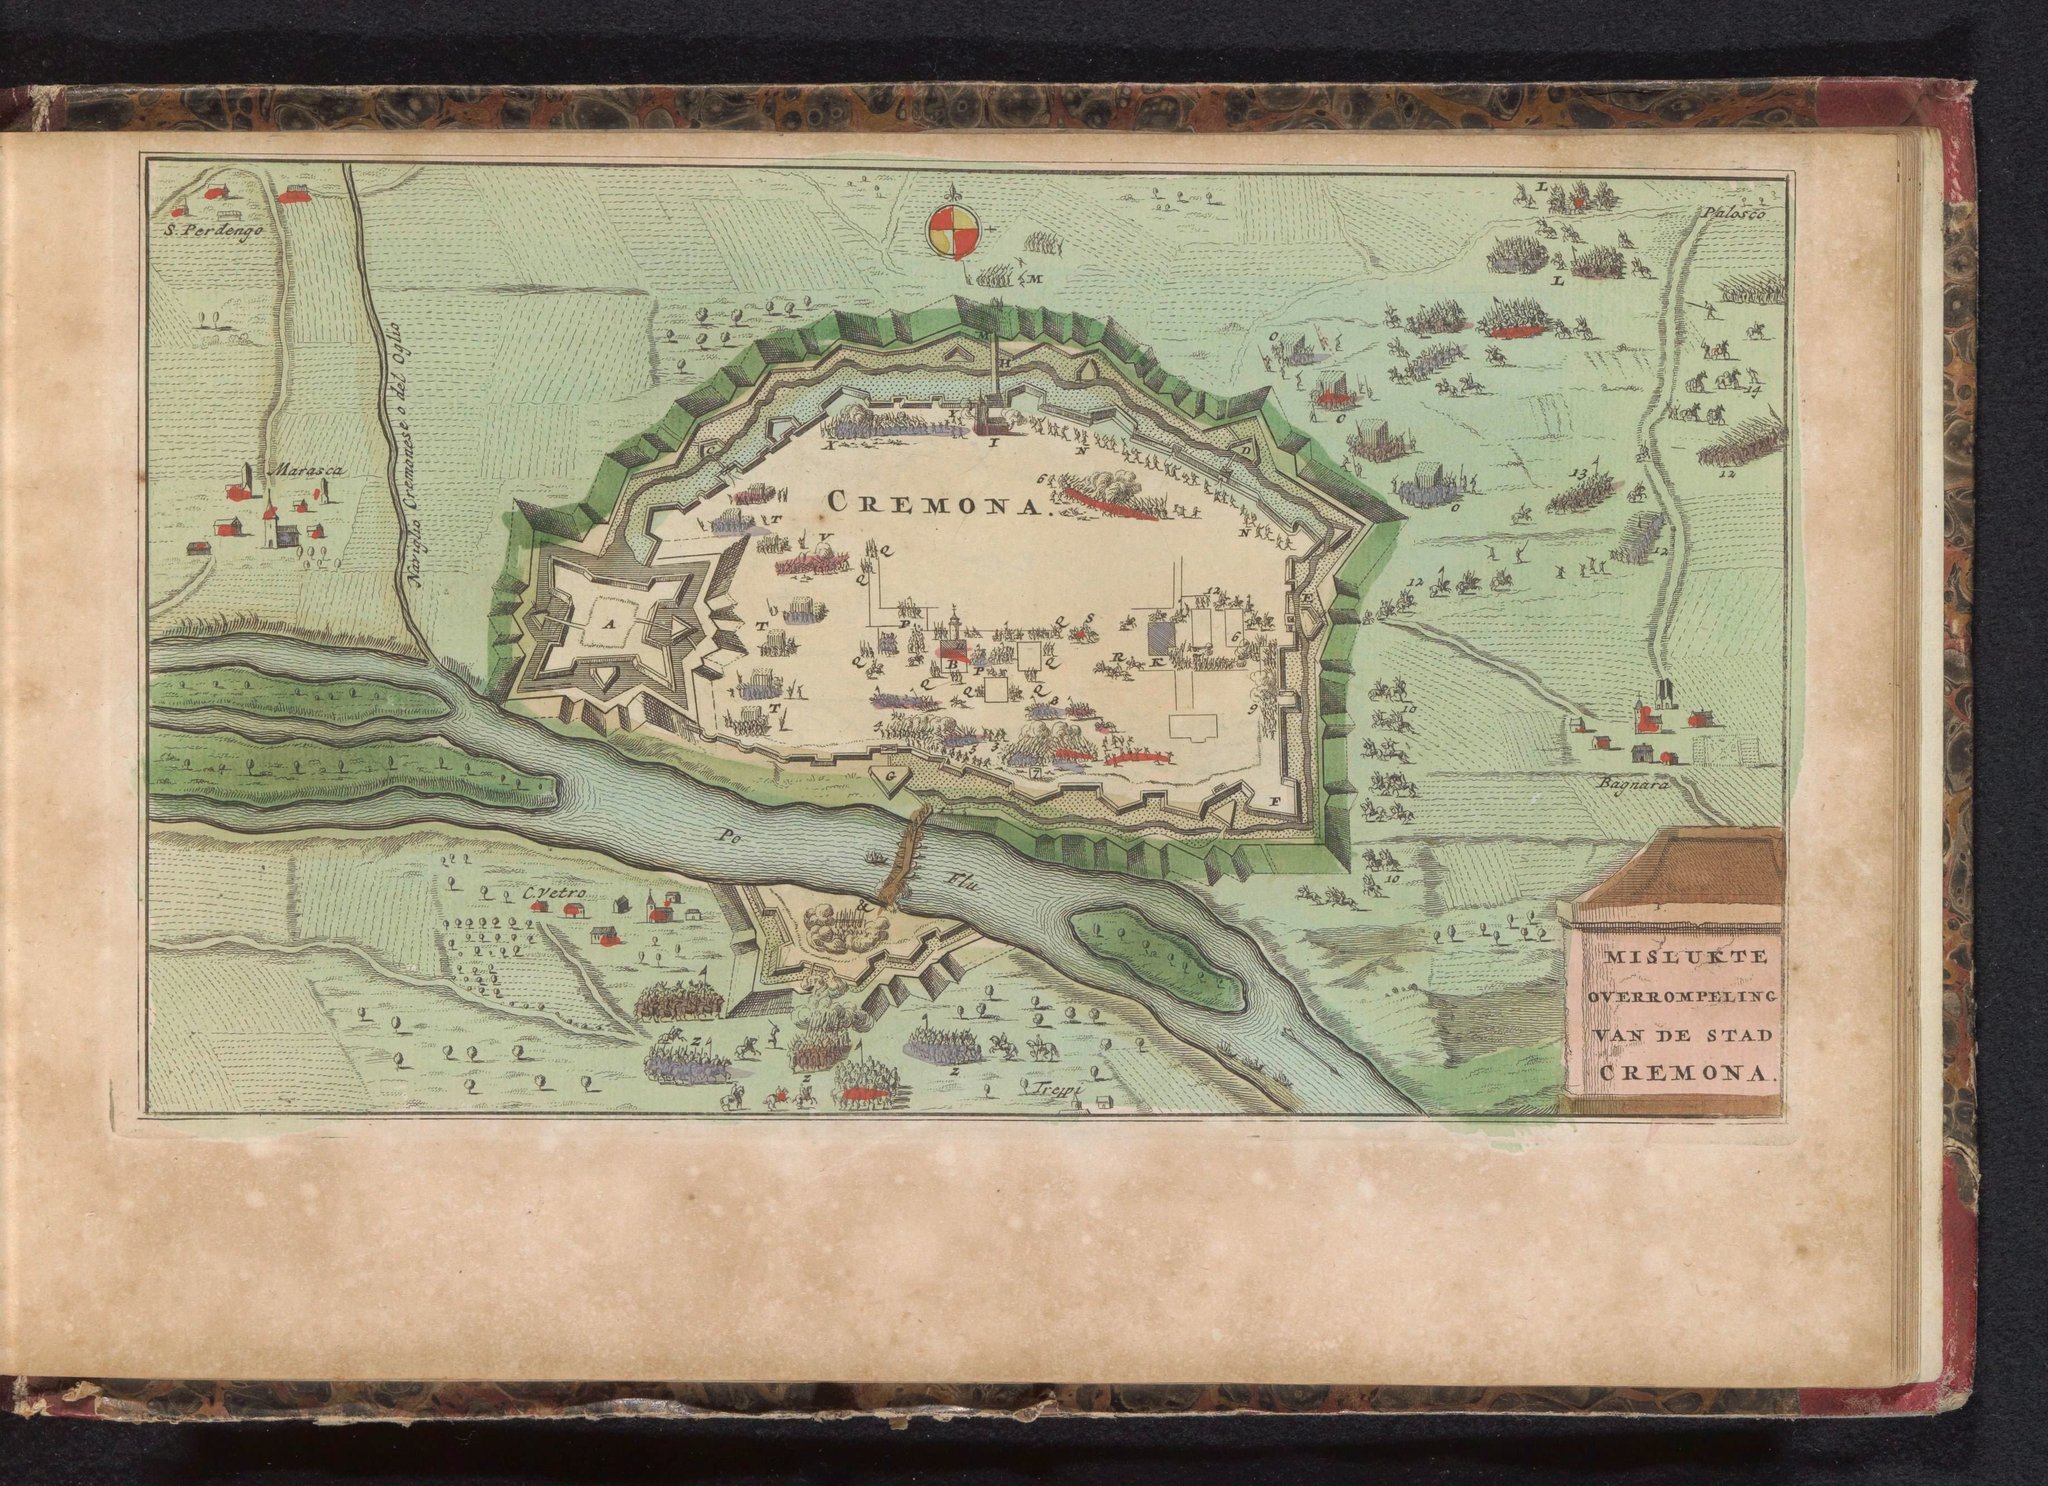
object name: print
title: Overval op Cremona, 1702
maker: Anonymous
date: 1700-1702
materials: paper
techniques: etching, hand coloring, lacquer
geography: northern netherlands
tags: capture of city (after the siege), maps of cities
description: Plattegrond van Cremona, ingenomen door het keizerlijke leger onder prins Eugenius van Savoye in de nacht van 31 januari op 1 februari 1702. Kort daarop heroveren de Fransen de stad. Onderdeel van een atlas met 223 kaarten van landen en steden en oorlogstaferelen in Europa in de periode ca. 1690-1735.